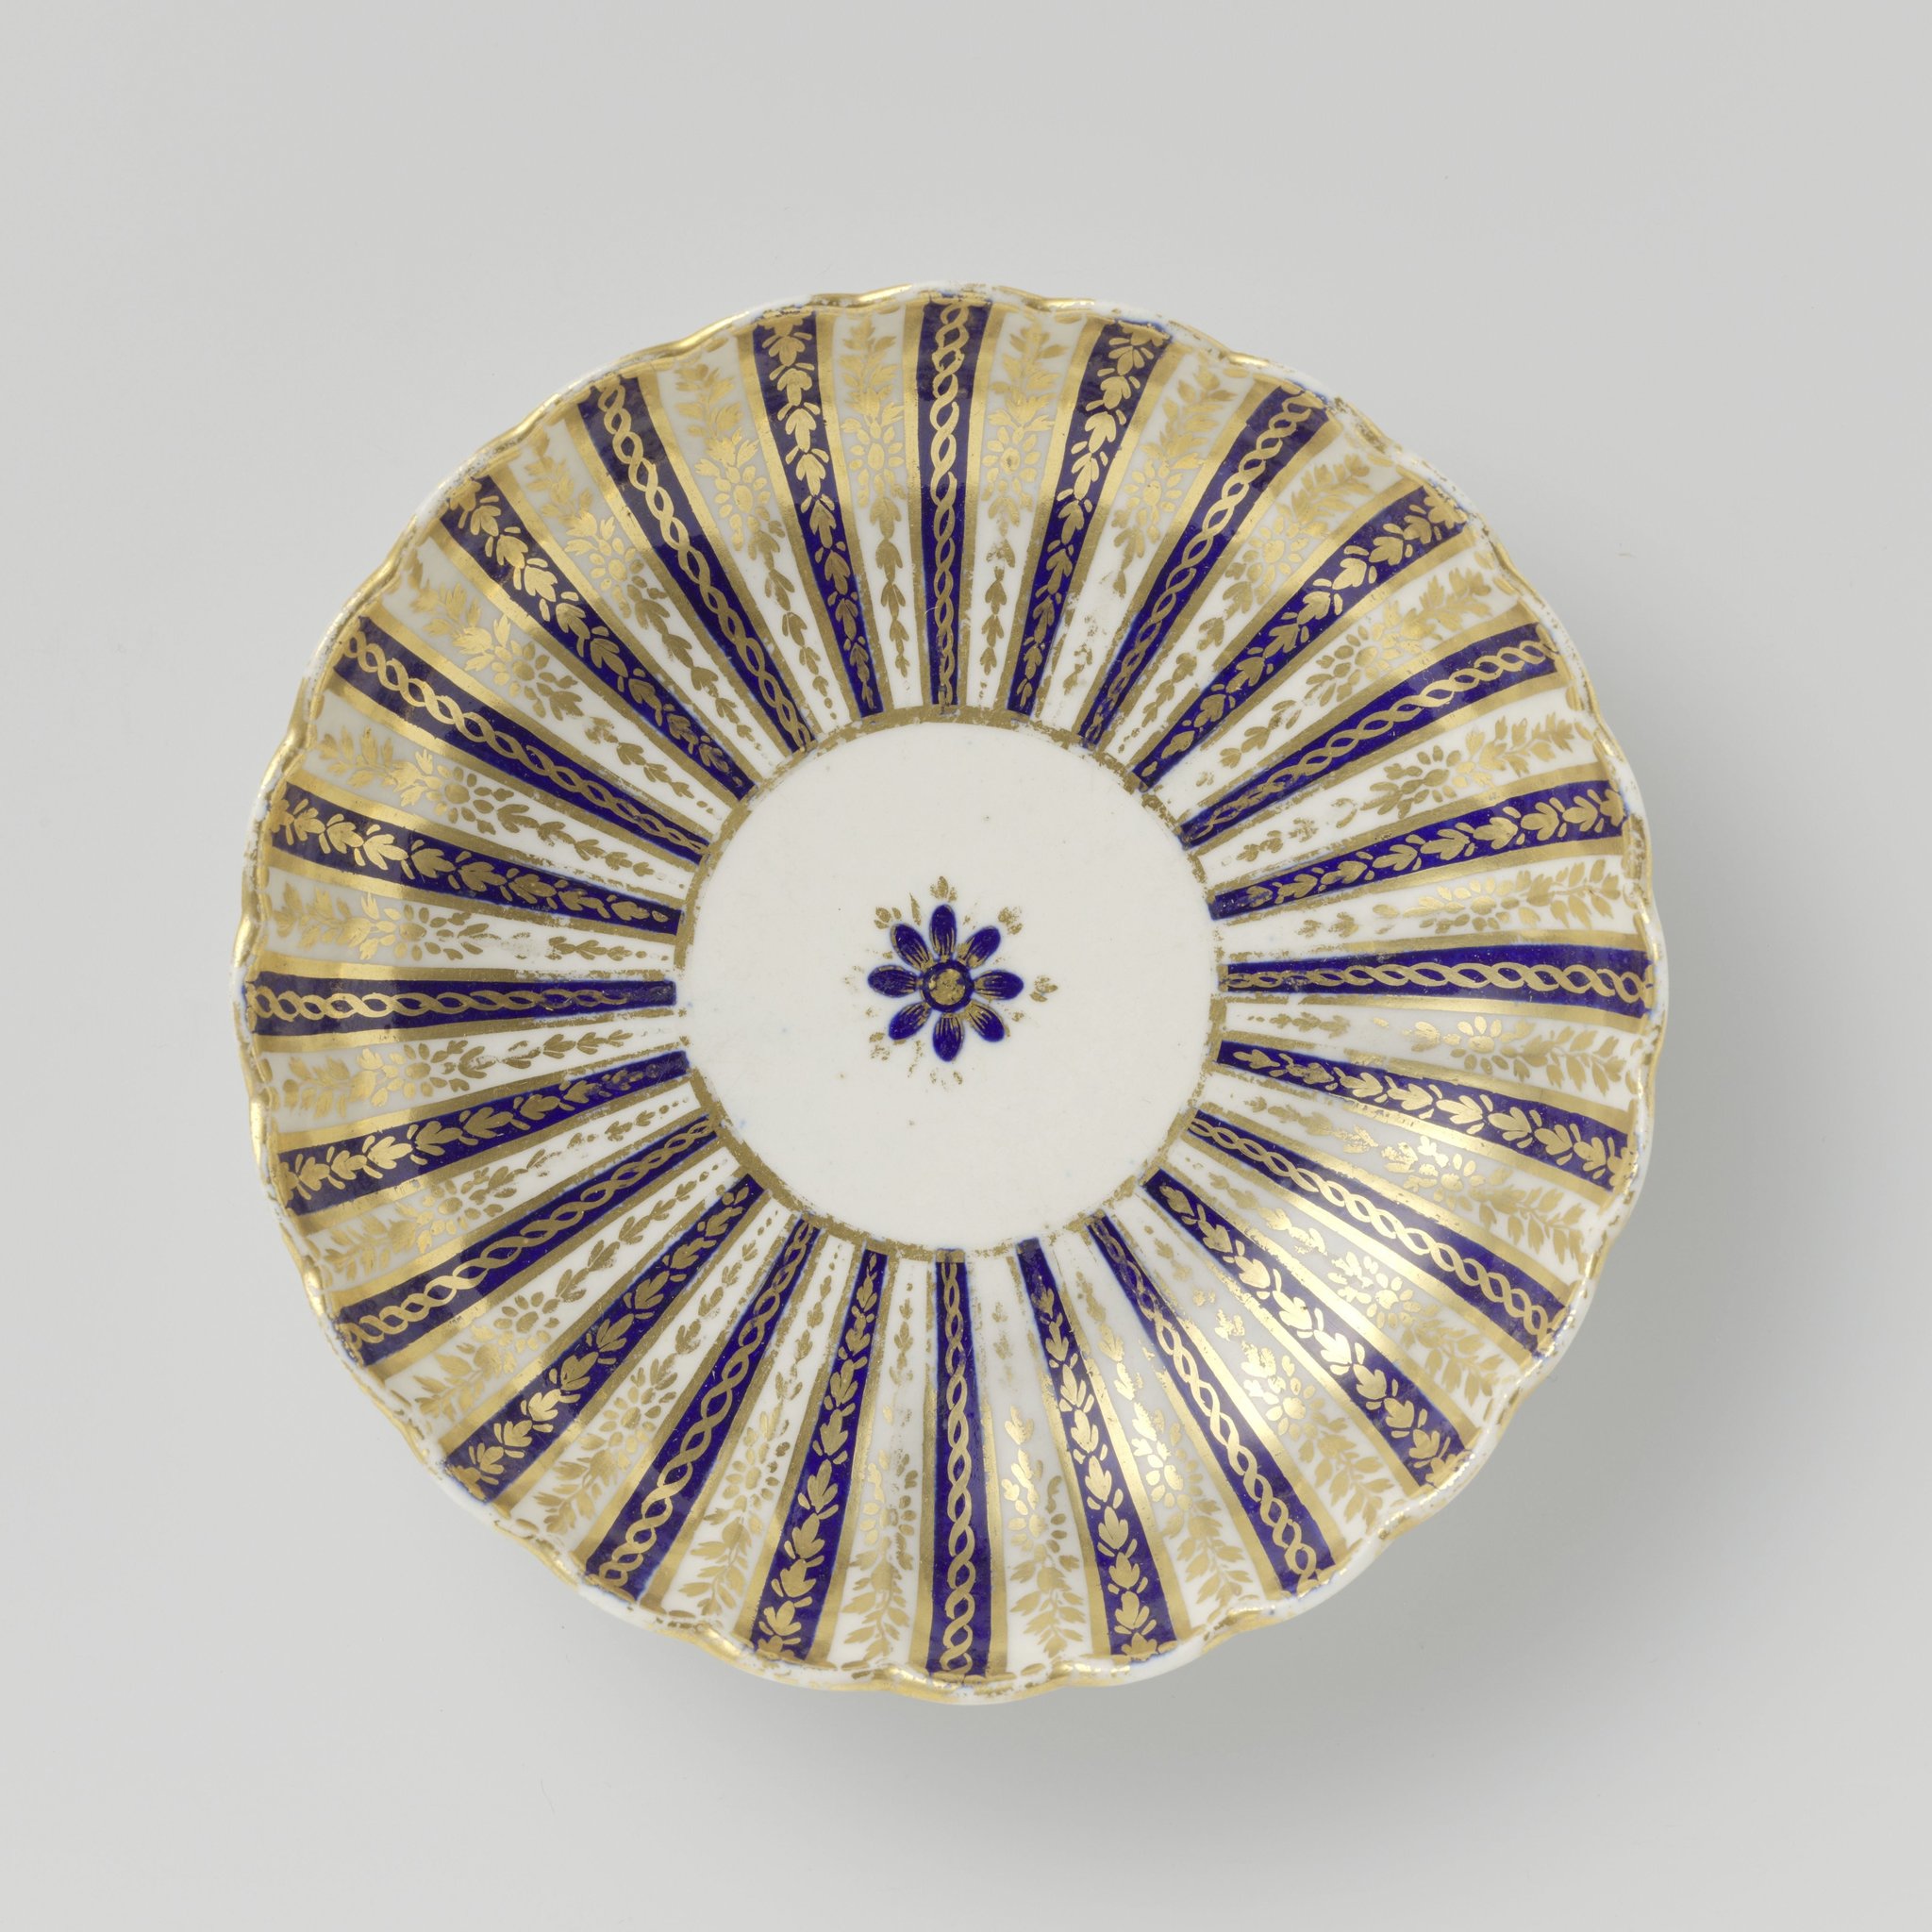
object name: platter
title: Schotel, de ribben afwisselend blauw en wit, gescheiden door gouden biezen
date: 1775-1800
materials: earthenware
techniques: vitrification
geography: worcester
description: Schotel, geribd, de randen gekarteld. De ribben door verticale gouden biezen gescheiden. De holtes donkerblauw (Blue du Roi), de ribben wit, waarop een versiering van bladwerk en vlechtband. De randen verguld, verguldsel naar binnen gekarteld. Gemerkt in onderglazuurblauw.